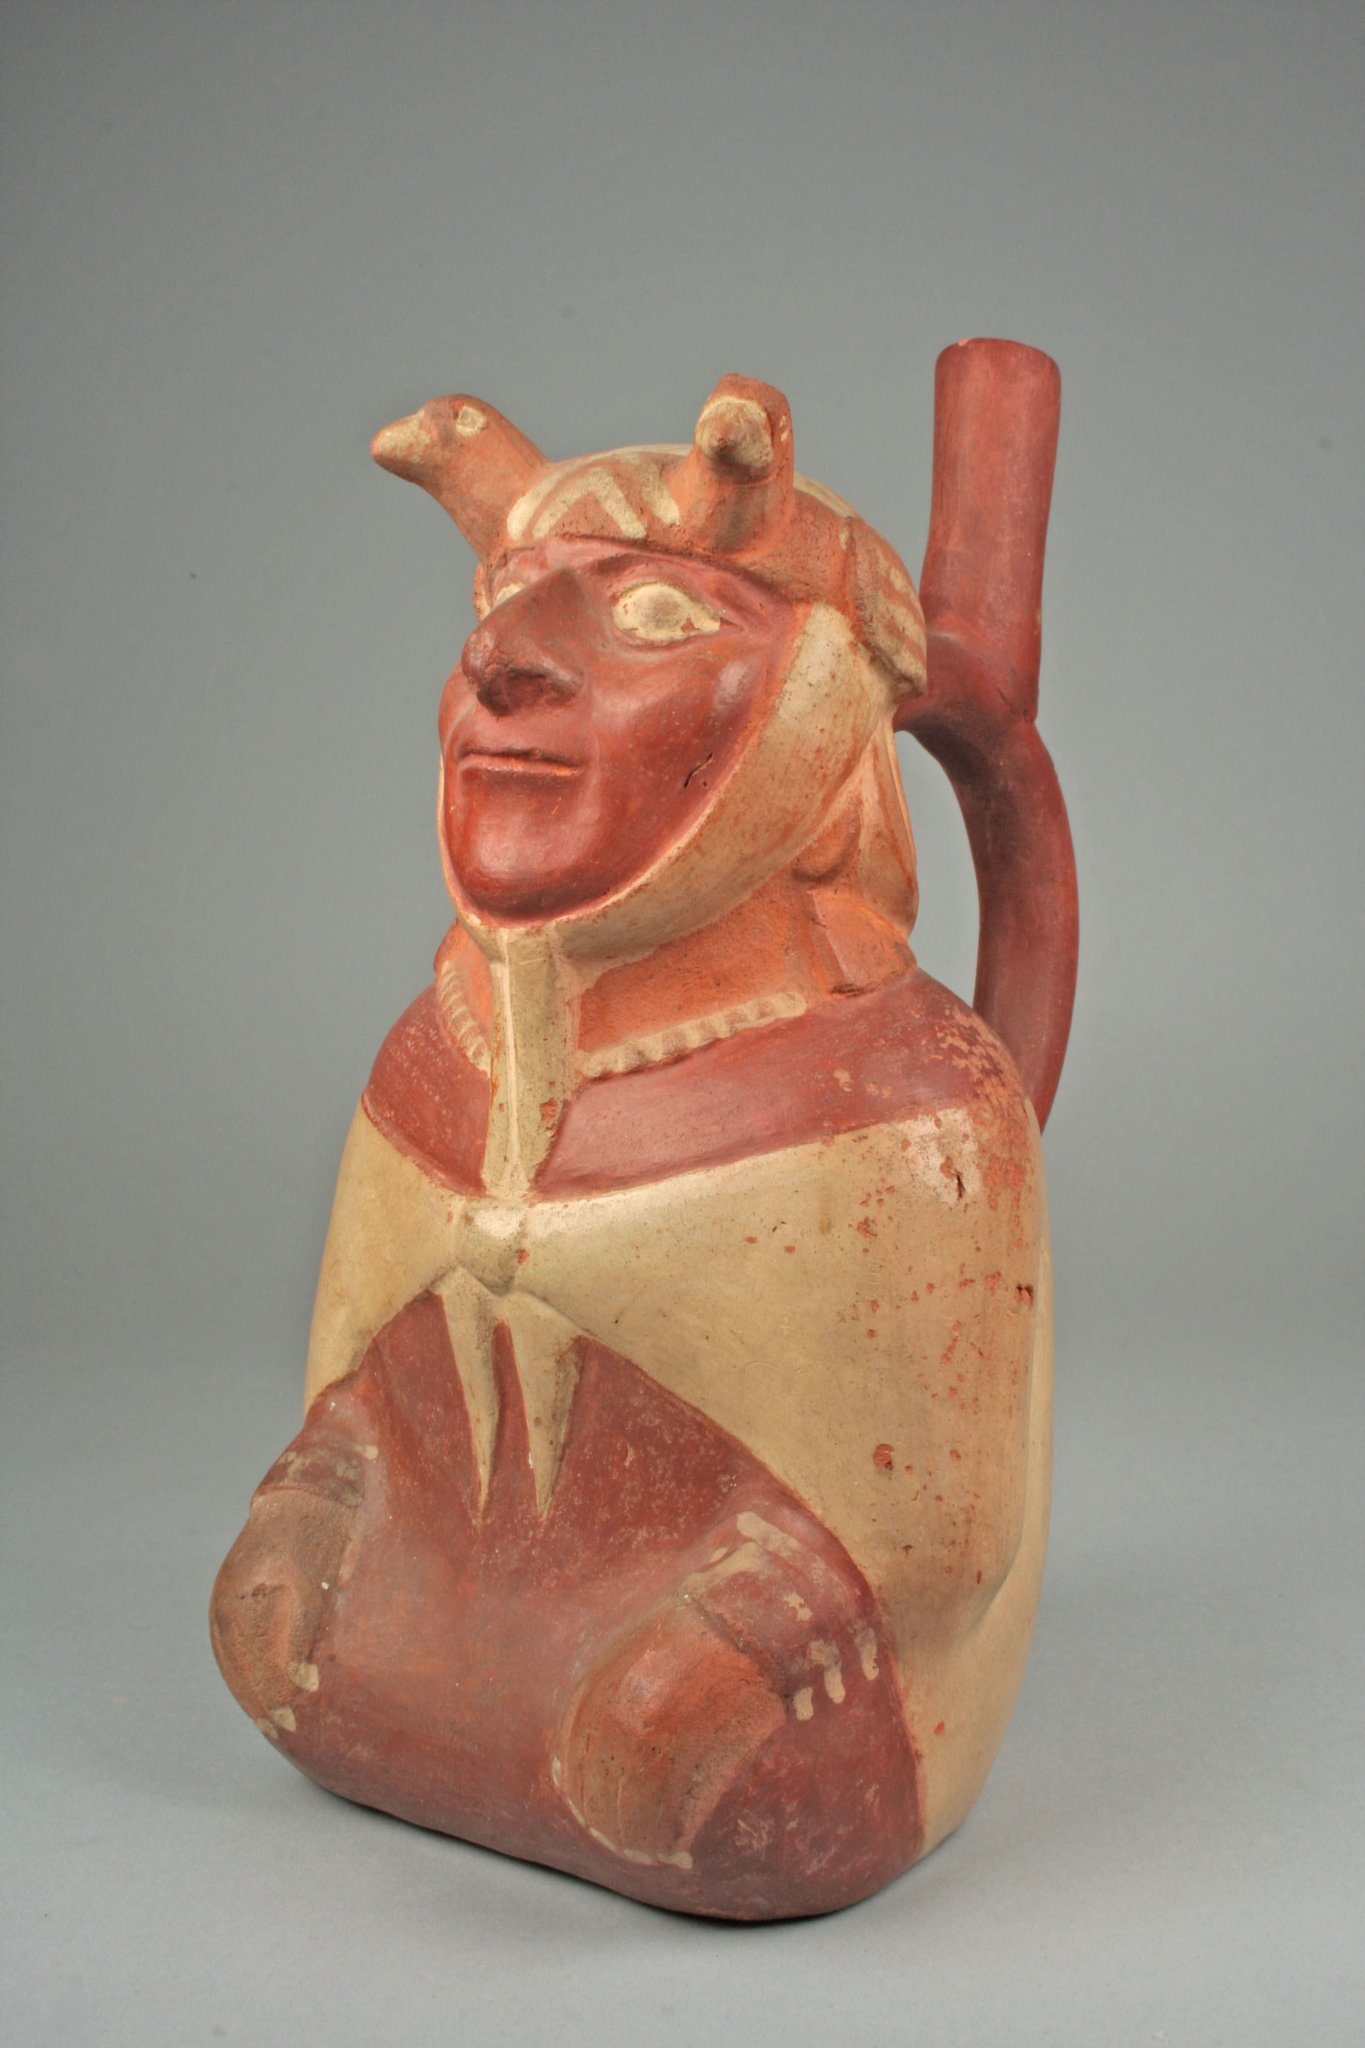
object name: bottle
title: Stirrup spout bottle with dignitary figure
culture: moche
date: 201-500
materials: ceramic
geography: peru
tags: human figures